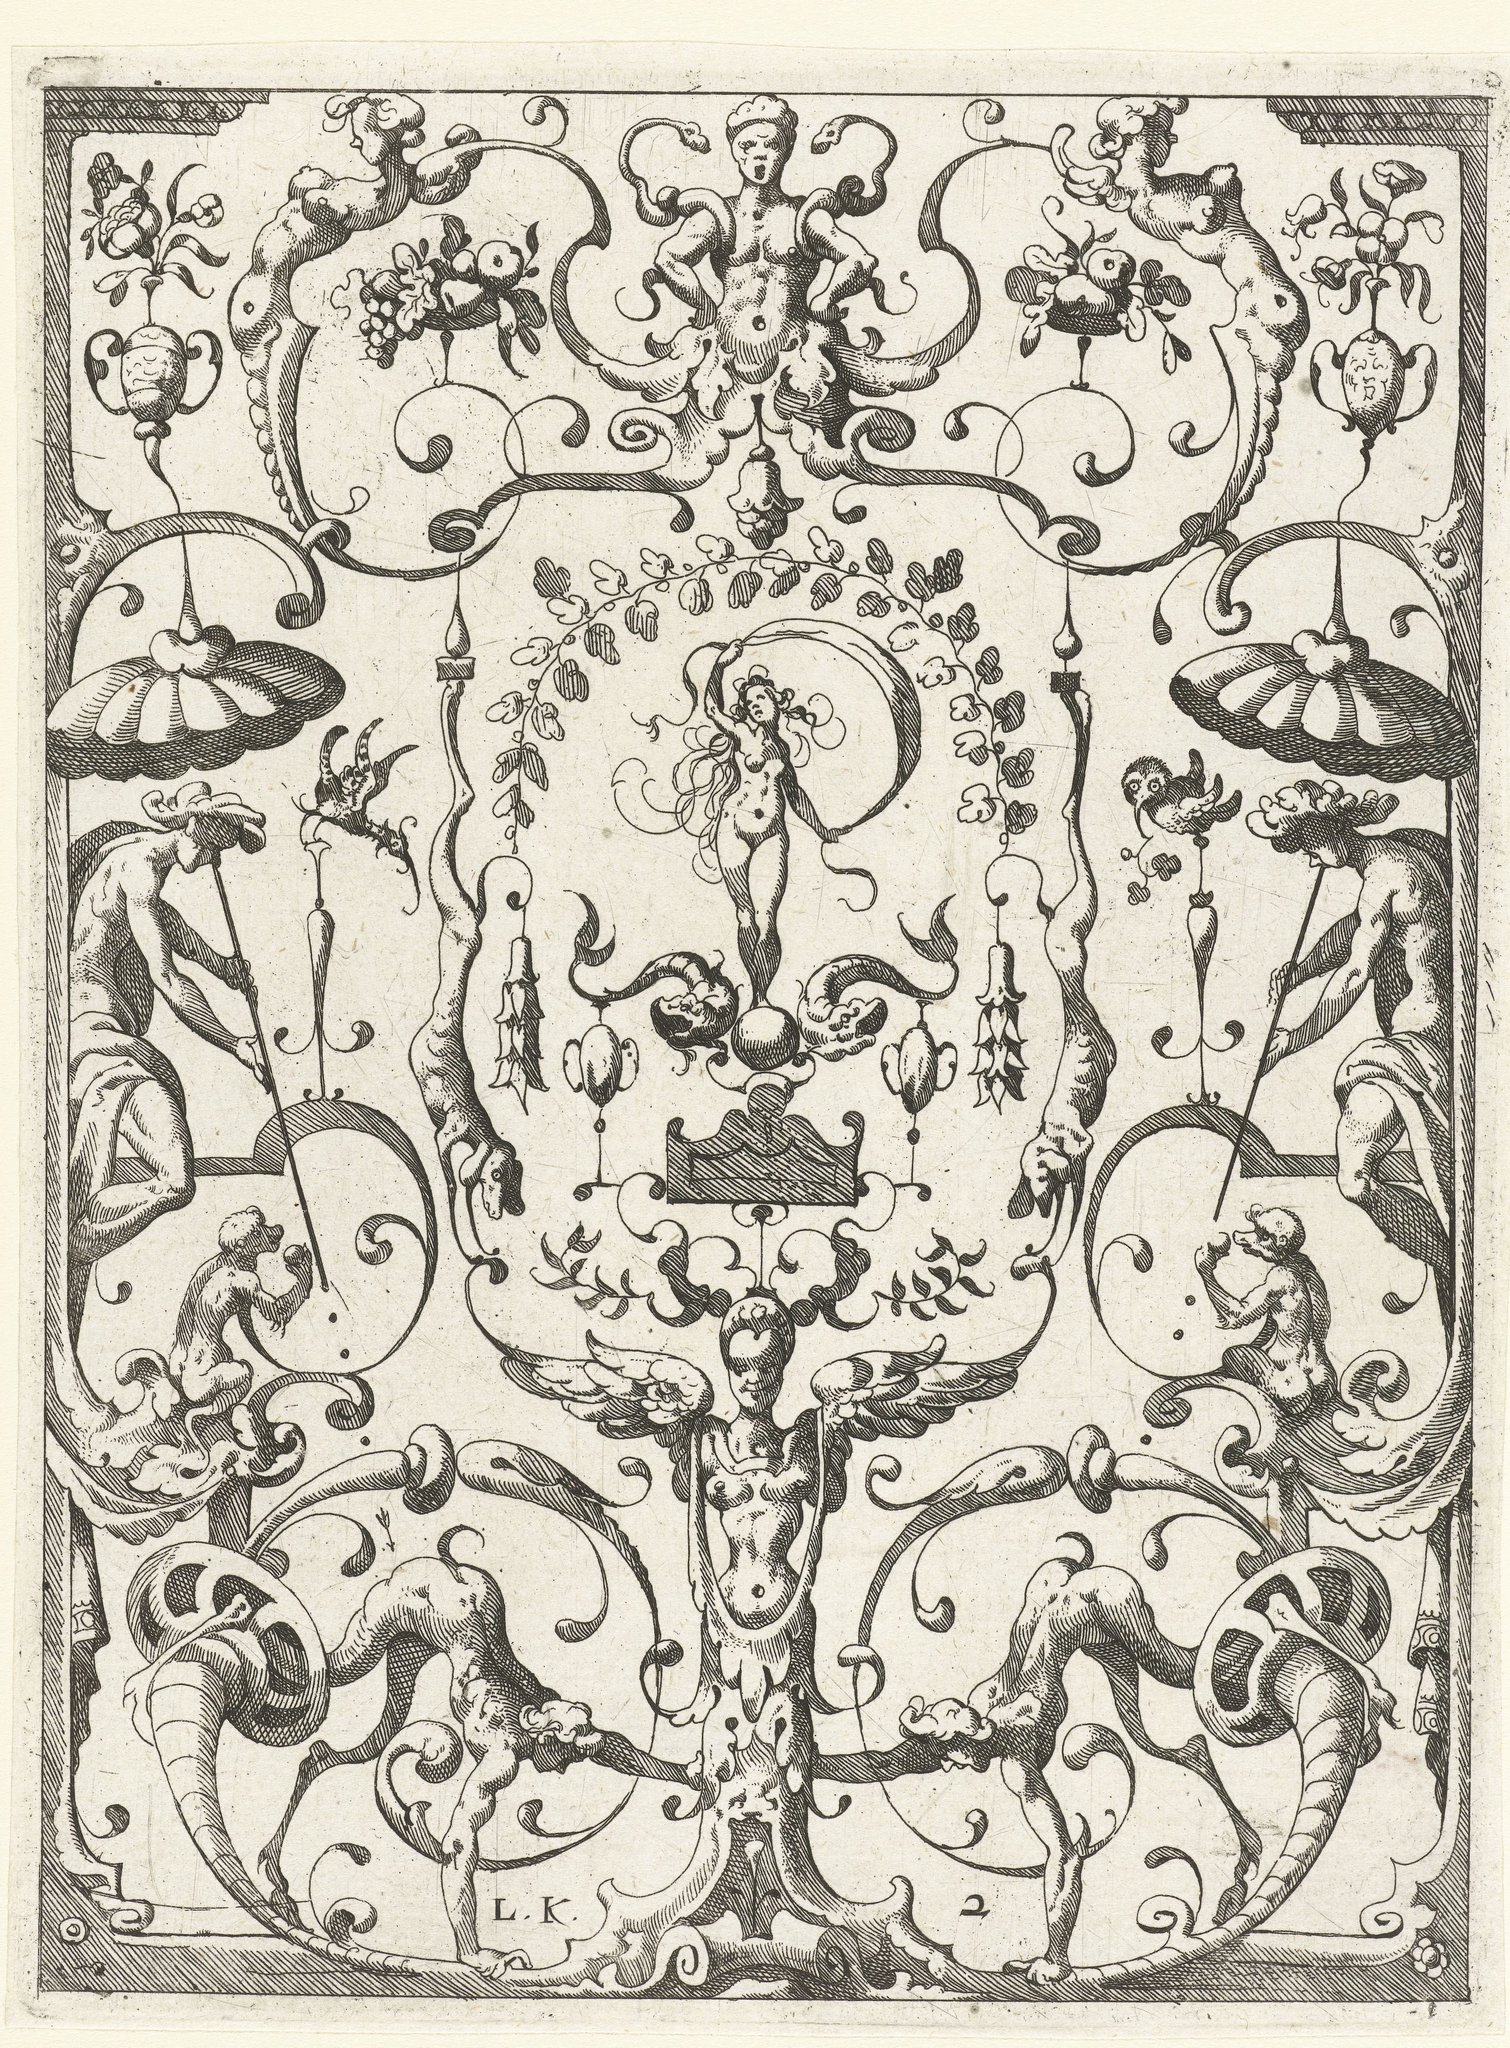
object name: print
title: Newes Gradesca Büchlein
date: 1607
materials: paper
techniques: etching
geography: augsburg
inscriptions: collector's mark: Lugt 240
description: In het midden staat Venus met twee dolfijnen aan haar voeten. Blad 2 uit serie met groteske vlakdecoraties met kwabornamenten.